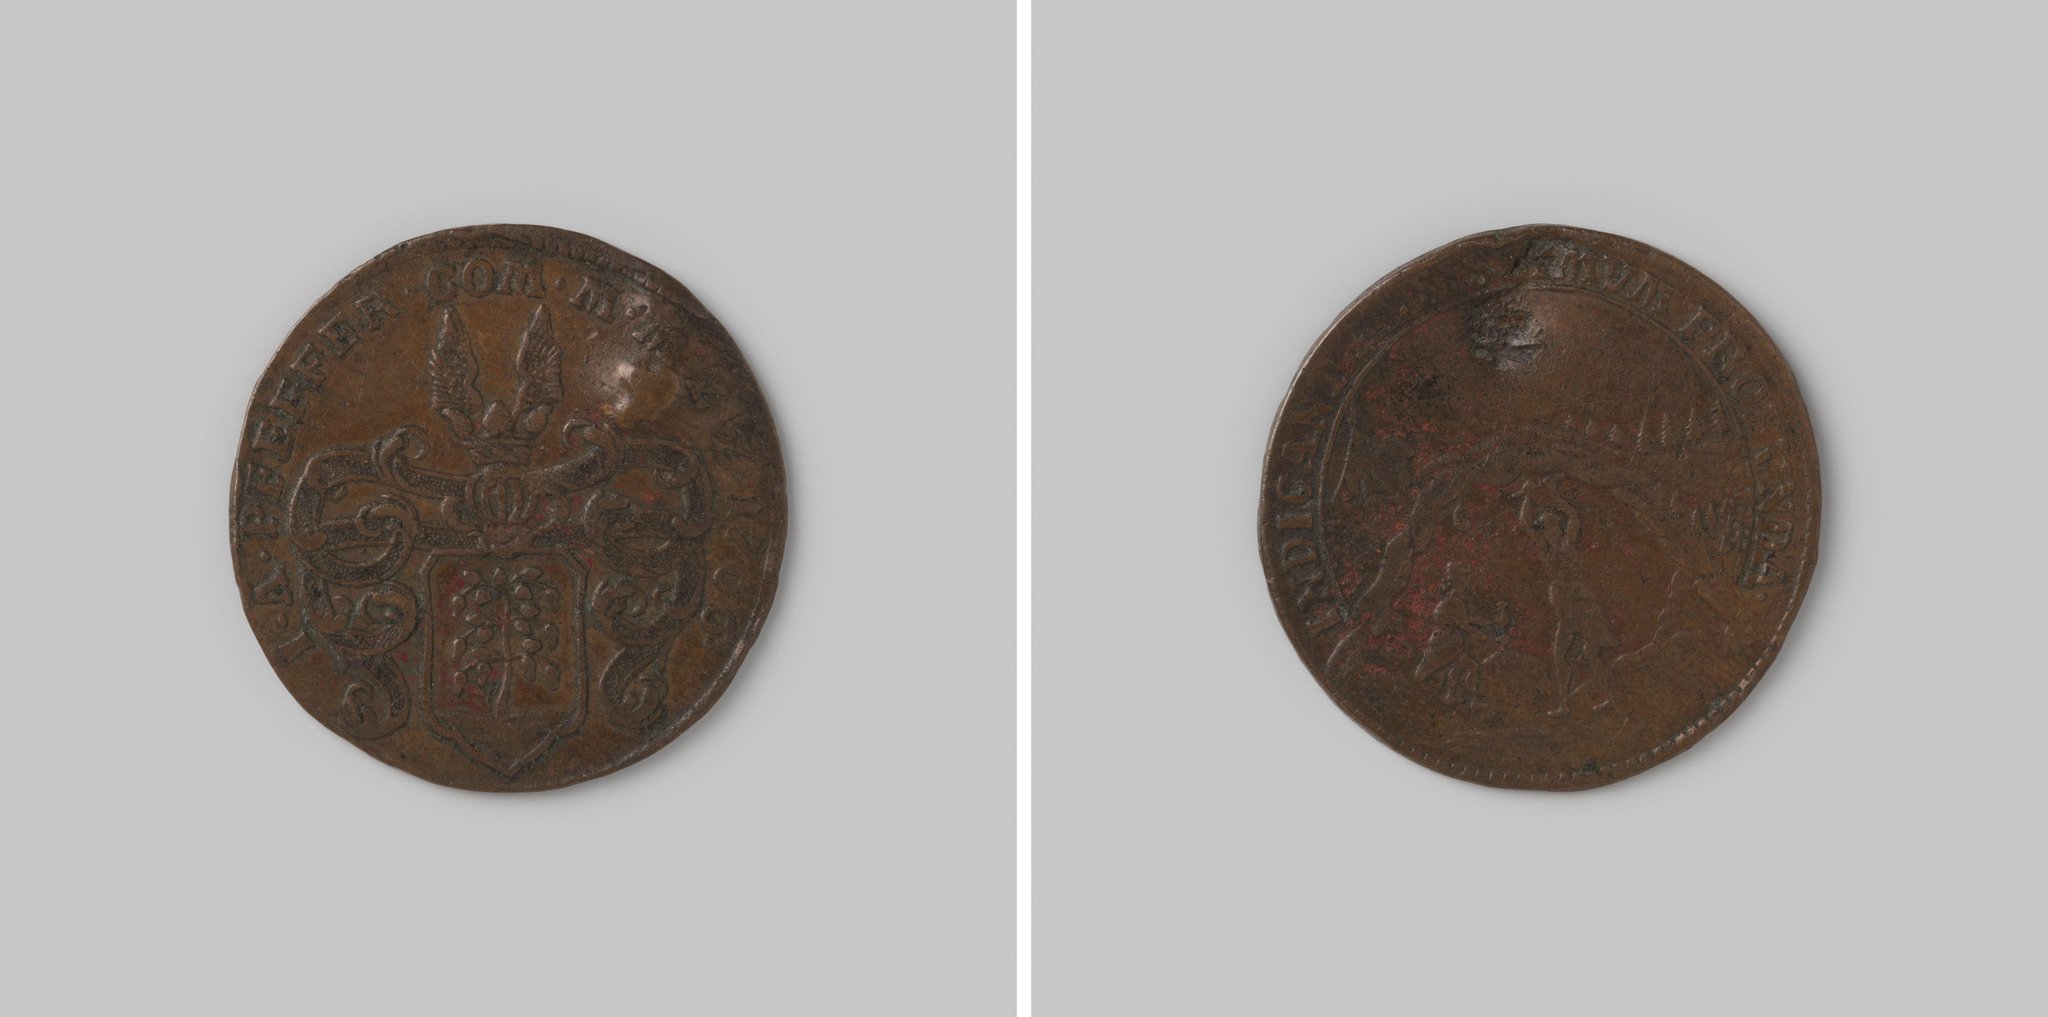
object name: history medal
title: Rekenpenning voor Johann Anton Pfeffer Muntmeester in Zellerveld 1766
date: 1766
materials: copper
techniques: striking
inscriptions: circumscription: ‘INDICANT ALTISSIMVM PROFVNDA’, circumscription: ‘I. A. PFEFFER. COM. M.M. Z. Z.’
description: Koperen penning met poging tot doorboring, op de voorzijde een gehelmd wapenschild met omschrift, op de keerzijde twee mijnwerkers in een mijngang, met omschrift.